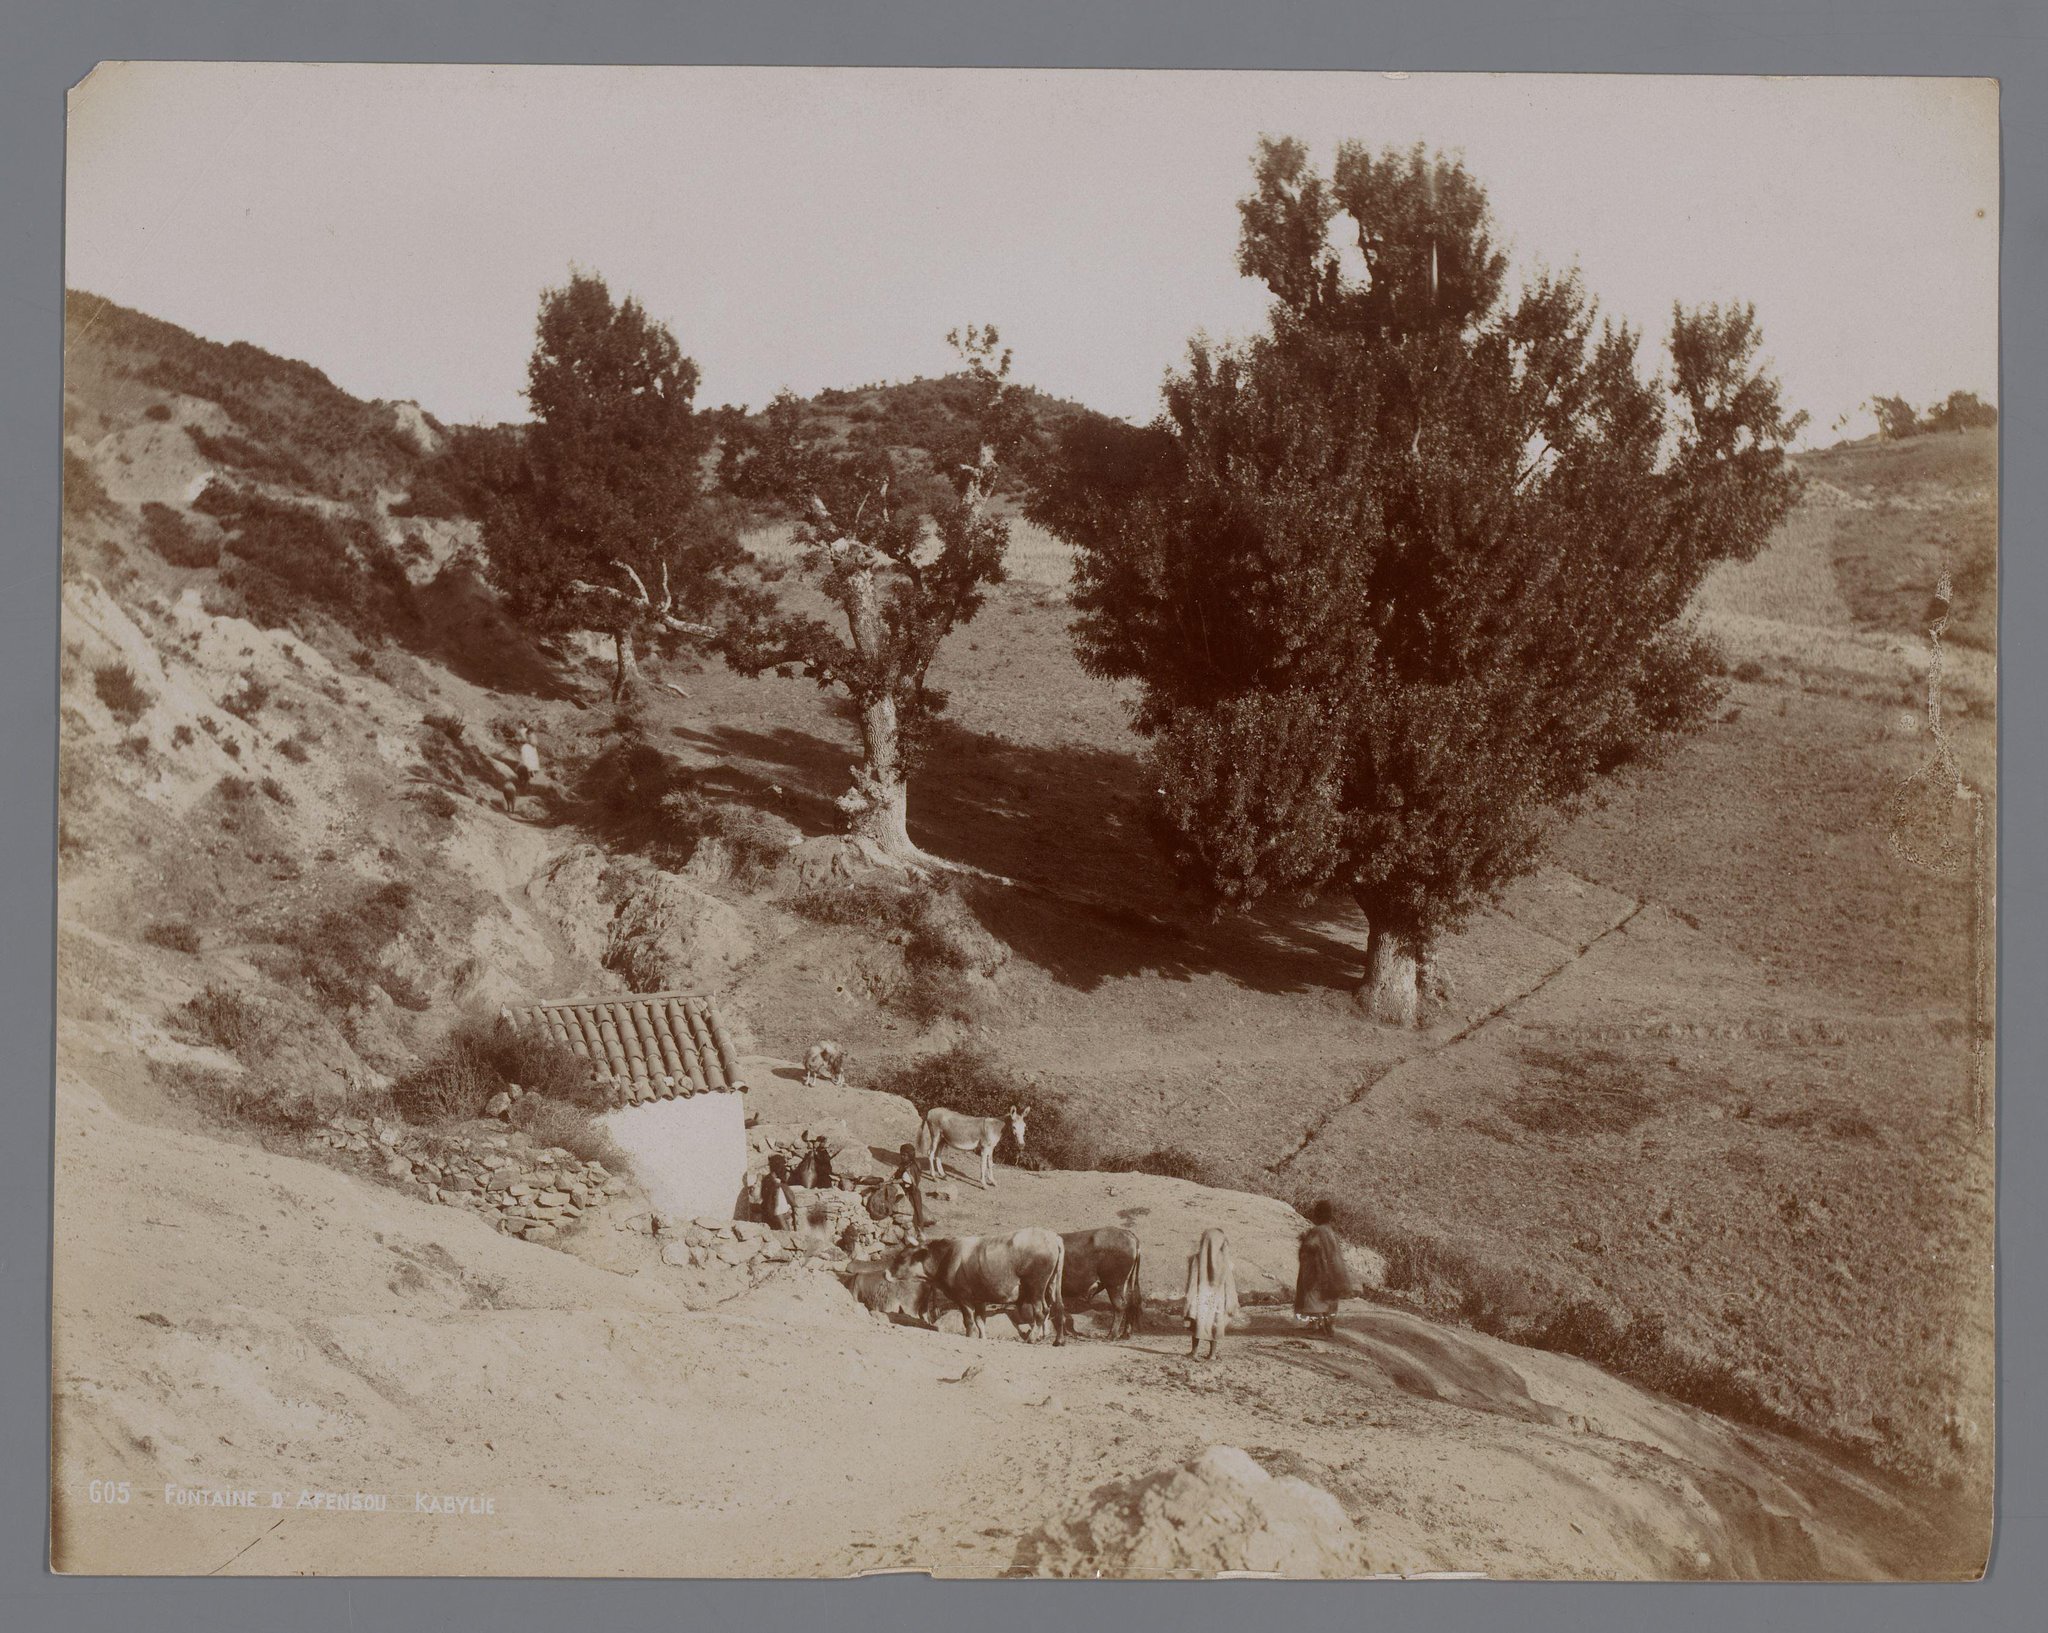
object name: photograph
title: Landschap met berbers [?], Kabylië, Marokko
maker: Anonymous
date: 1880-1900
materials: paper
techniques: gelatin silver print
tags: marokko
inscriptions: inscription: ‘Fontaine d'Afensou Kabylie’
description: Nota Bene: [?] Afensou is stad in Marokko; Kabylië is een cultuurlandschap in het noorden van Algerije en bestrijkt 7 provincies.